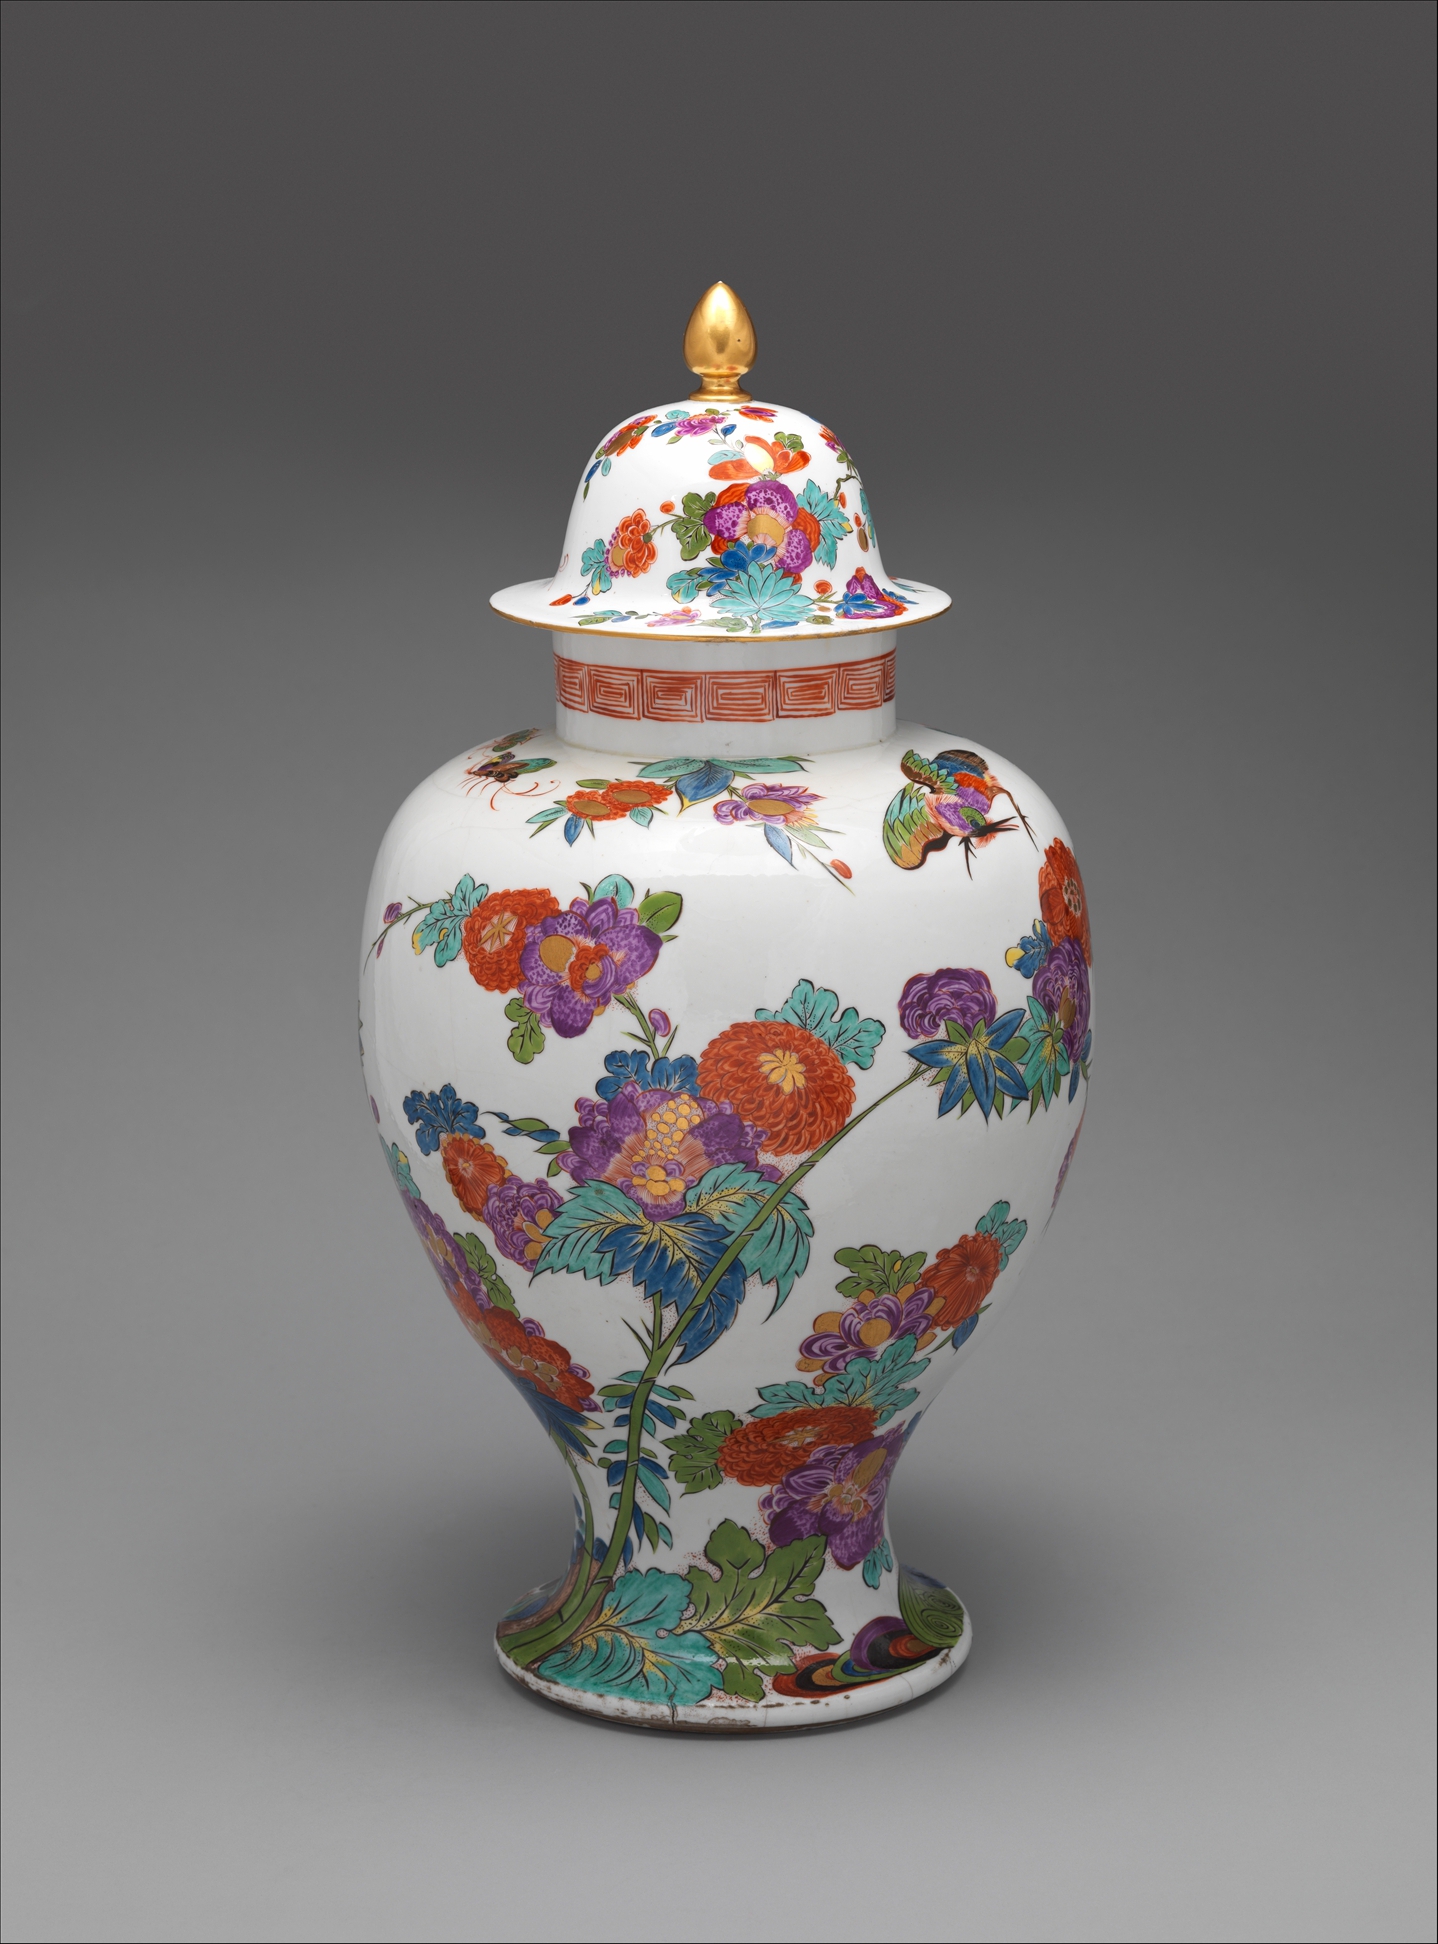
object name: vase with cover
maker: meissen manufactory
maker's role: manufactory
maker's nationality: german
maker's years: 1710-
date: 1725-1730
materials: hard paste porcelain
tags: flowers